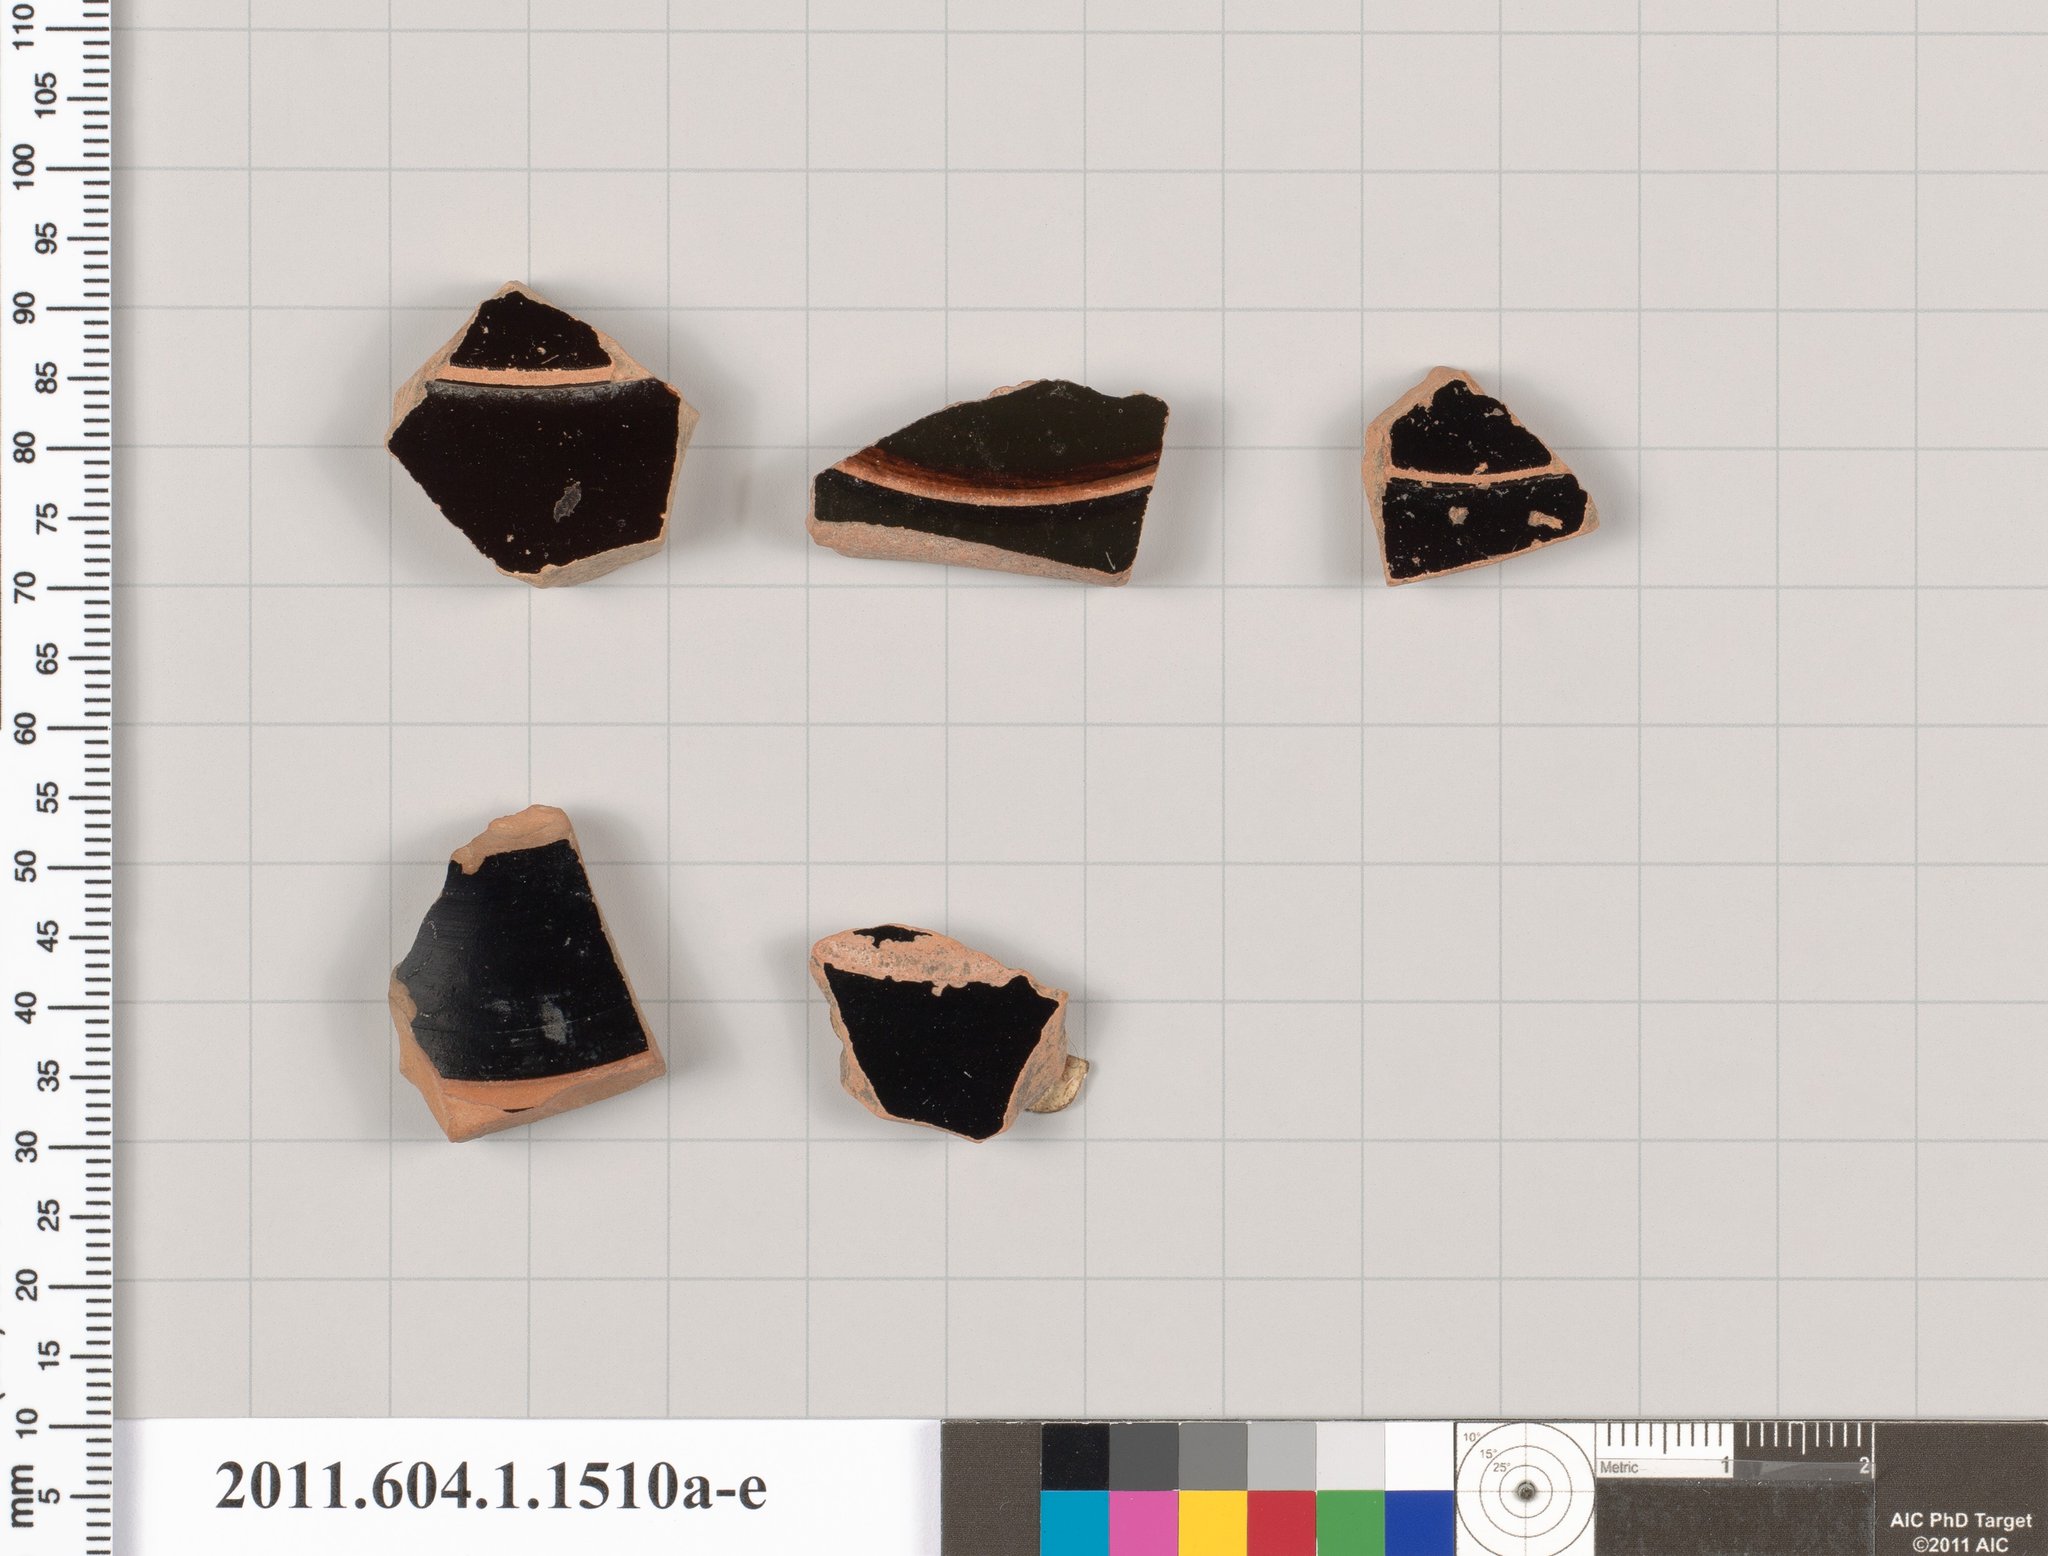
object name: kylix fragment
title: Terracotta fragments of kylikes (drinking cups)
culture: greek, attic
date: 500-401 BCE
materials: terracotta